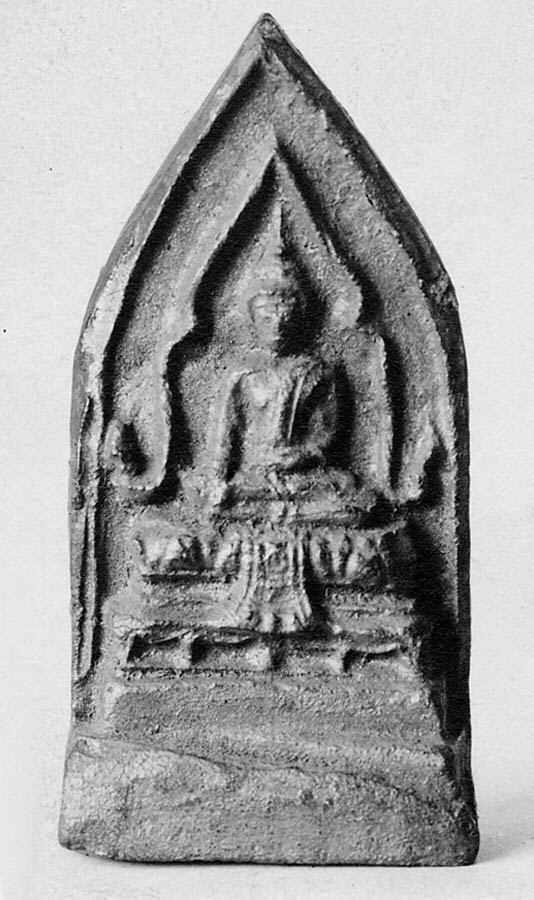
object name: plaque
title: Seated Buddha Enthroned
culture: thai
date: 1801-1900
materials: clay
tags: buddhism,buddha